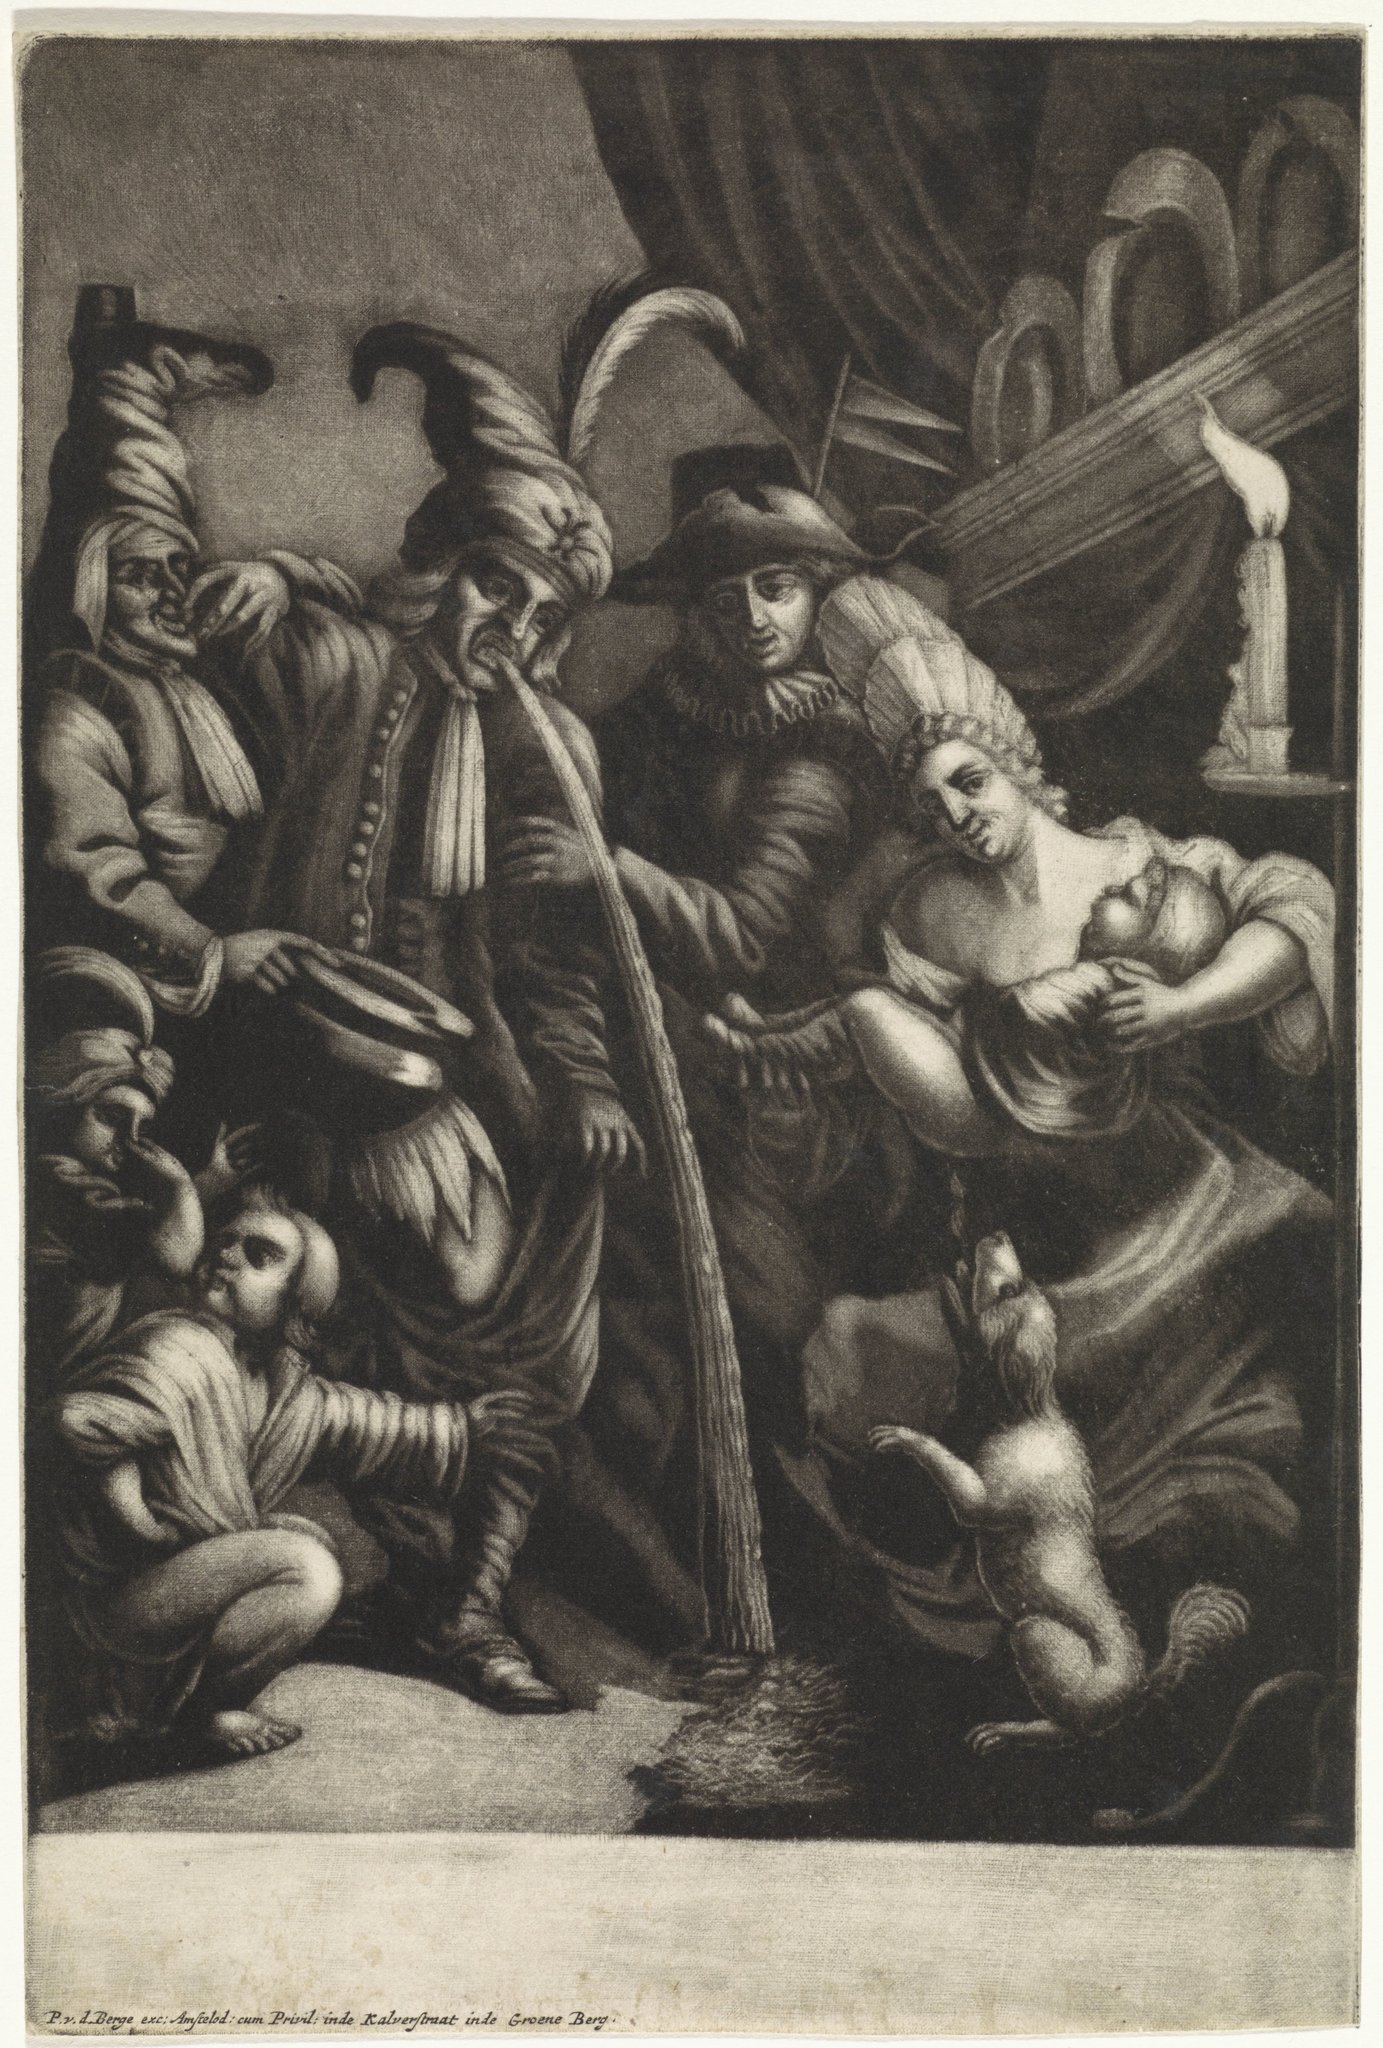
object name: print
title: Dwaas gezelschap in een vertrek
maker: pieter van den berge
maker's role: draughtsman, print maker, printer, publisher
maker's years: 1659-1737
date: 1692-1737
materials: paper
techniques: engraving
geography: amsterdam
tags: vomiting, defecation, dog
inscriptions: collector's mark: Lugt 2228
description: In een vertrek bevindt zich een aantal mensen bij de haard, waaronder een overgevende man en poepende kinderen.